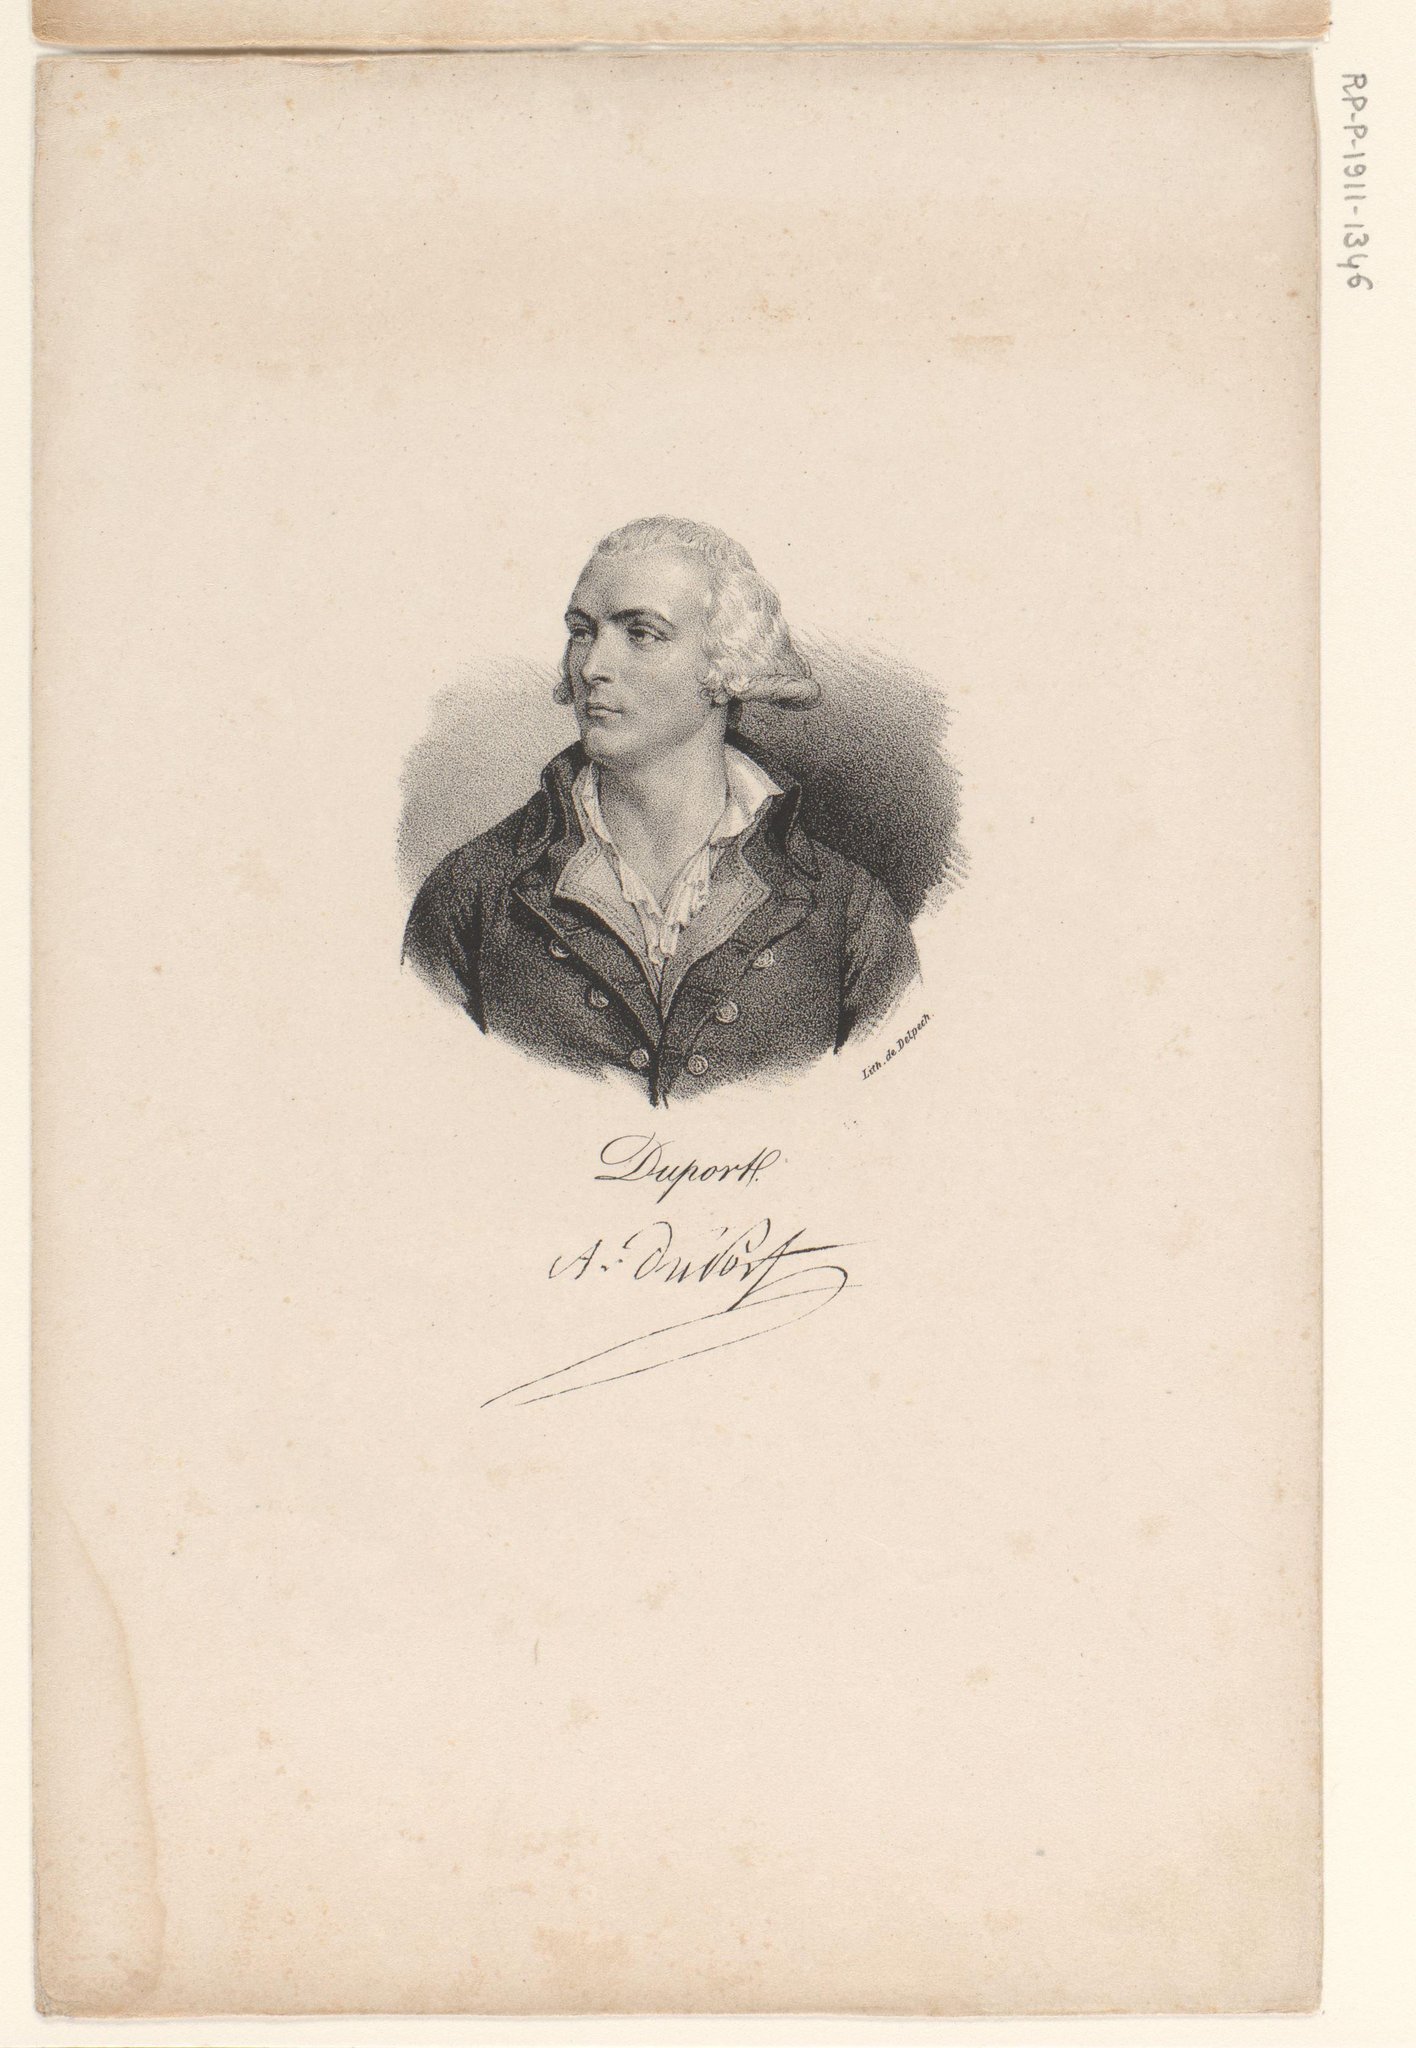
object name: print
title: Portret van Adrien Duport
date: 1818-1842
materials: paper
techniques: lithograph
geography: paris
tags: historical persons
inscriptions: collector's mark: Lugt 2228a